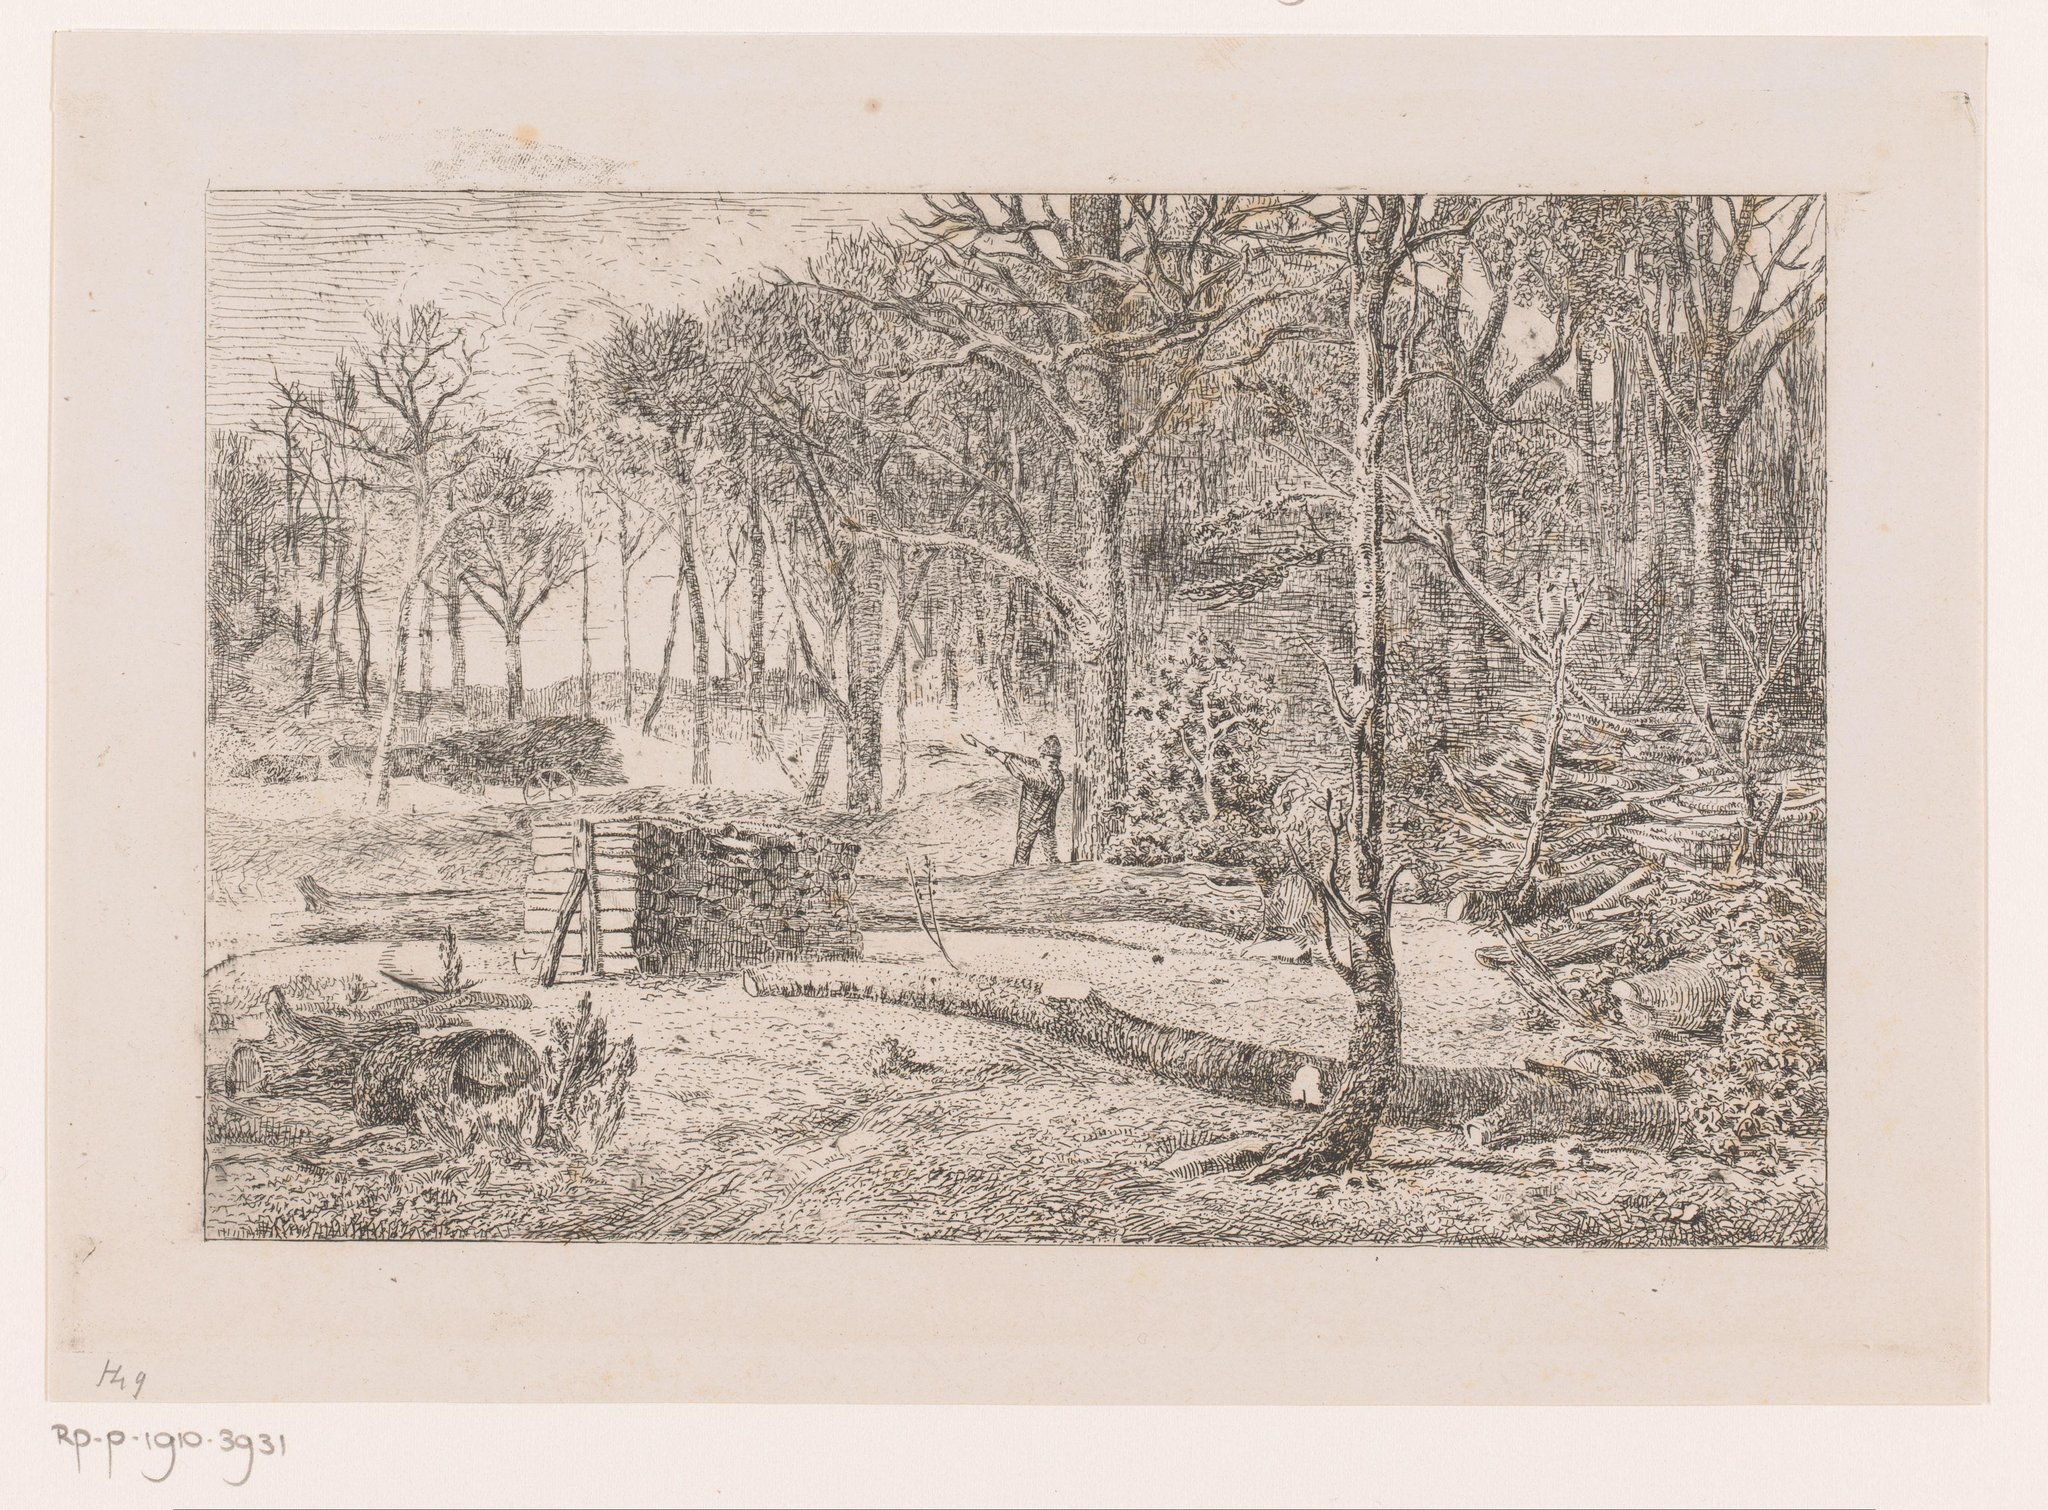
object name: print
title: Houthakker in het bos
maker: lambert jacquelart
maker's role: print maker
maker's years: 1820-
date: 1830-1910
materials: paper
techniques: etching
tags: woodcutting, woodcutter ~ forestry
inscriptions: collector's mark: Lugt 2228, collector's mark: Lugt 1485